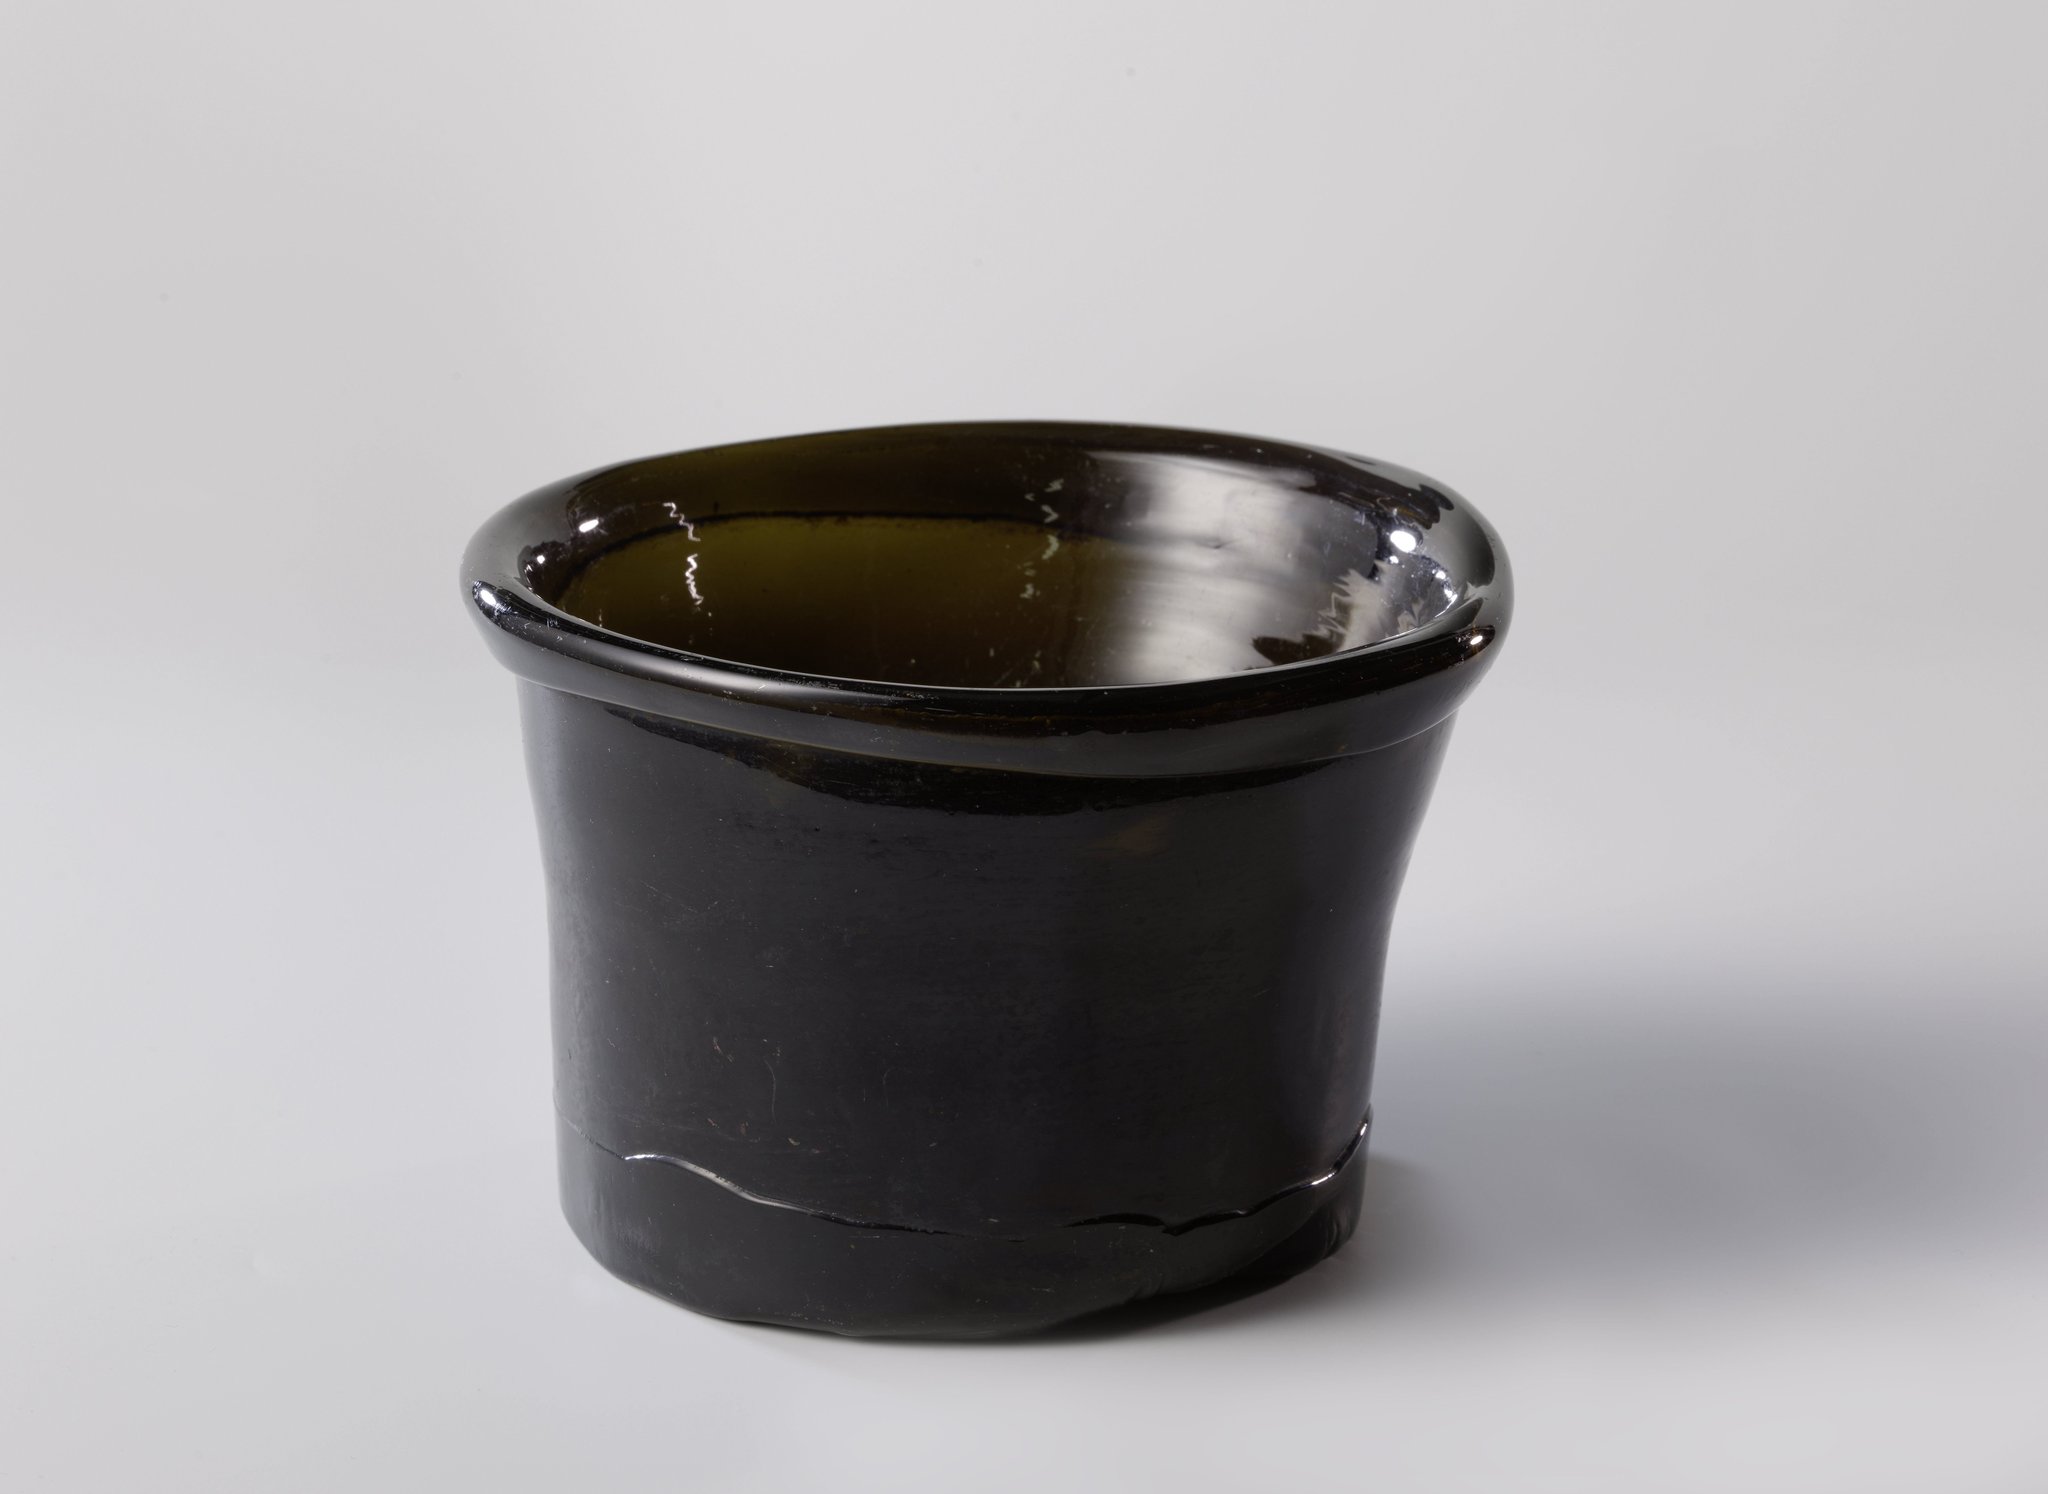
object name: mortar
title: Vijzel van bruingroen glas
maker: Anonymous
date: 1700-1900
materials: glass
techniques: glassblowing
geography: northwest europe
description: Vijzel met licht concaaf lichaam met omgeslagen rand, aan de onderzijde afgezet met een platte, licht geribde band.